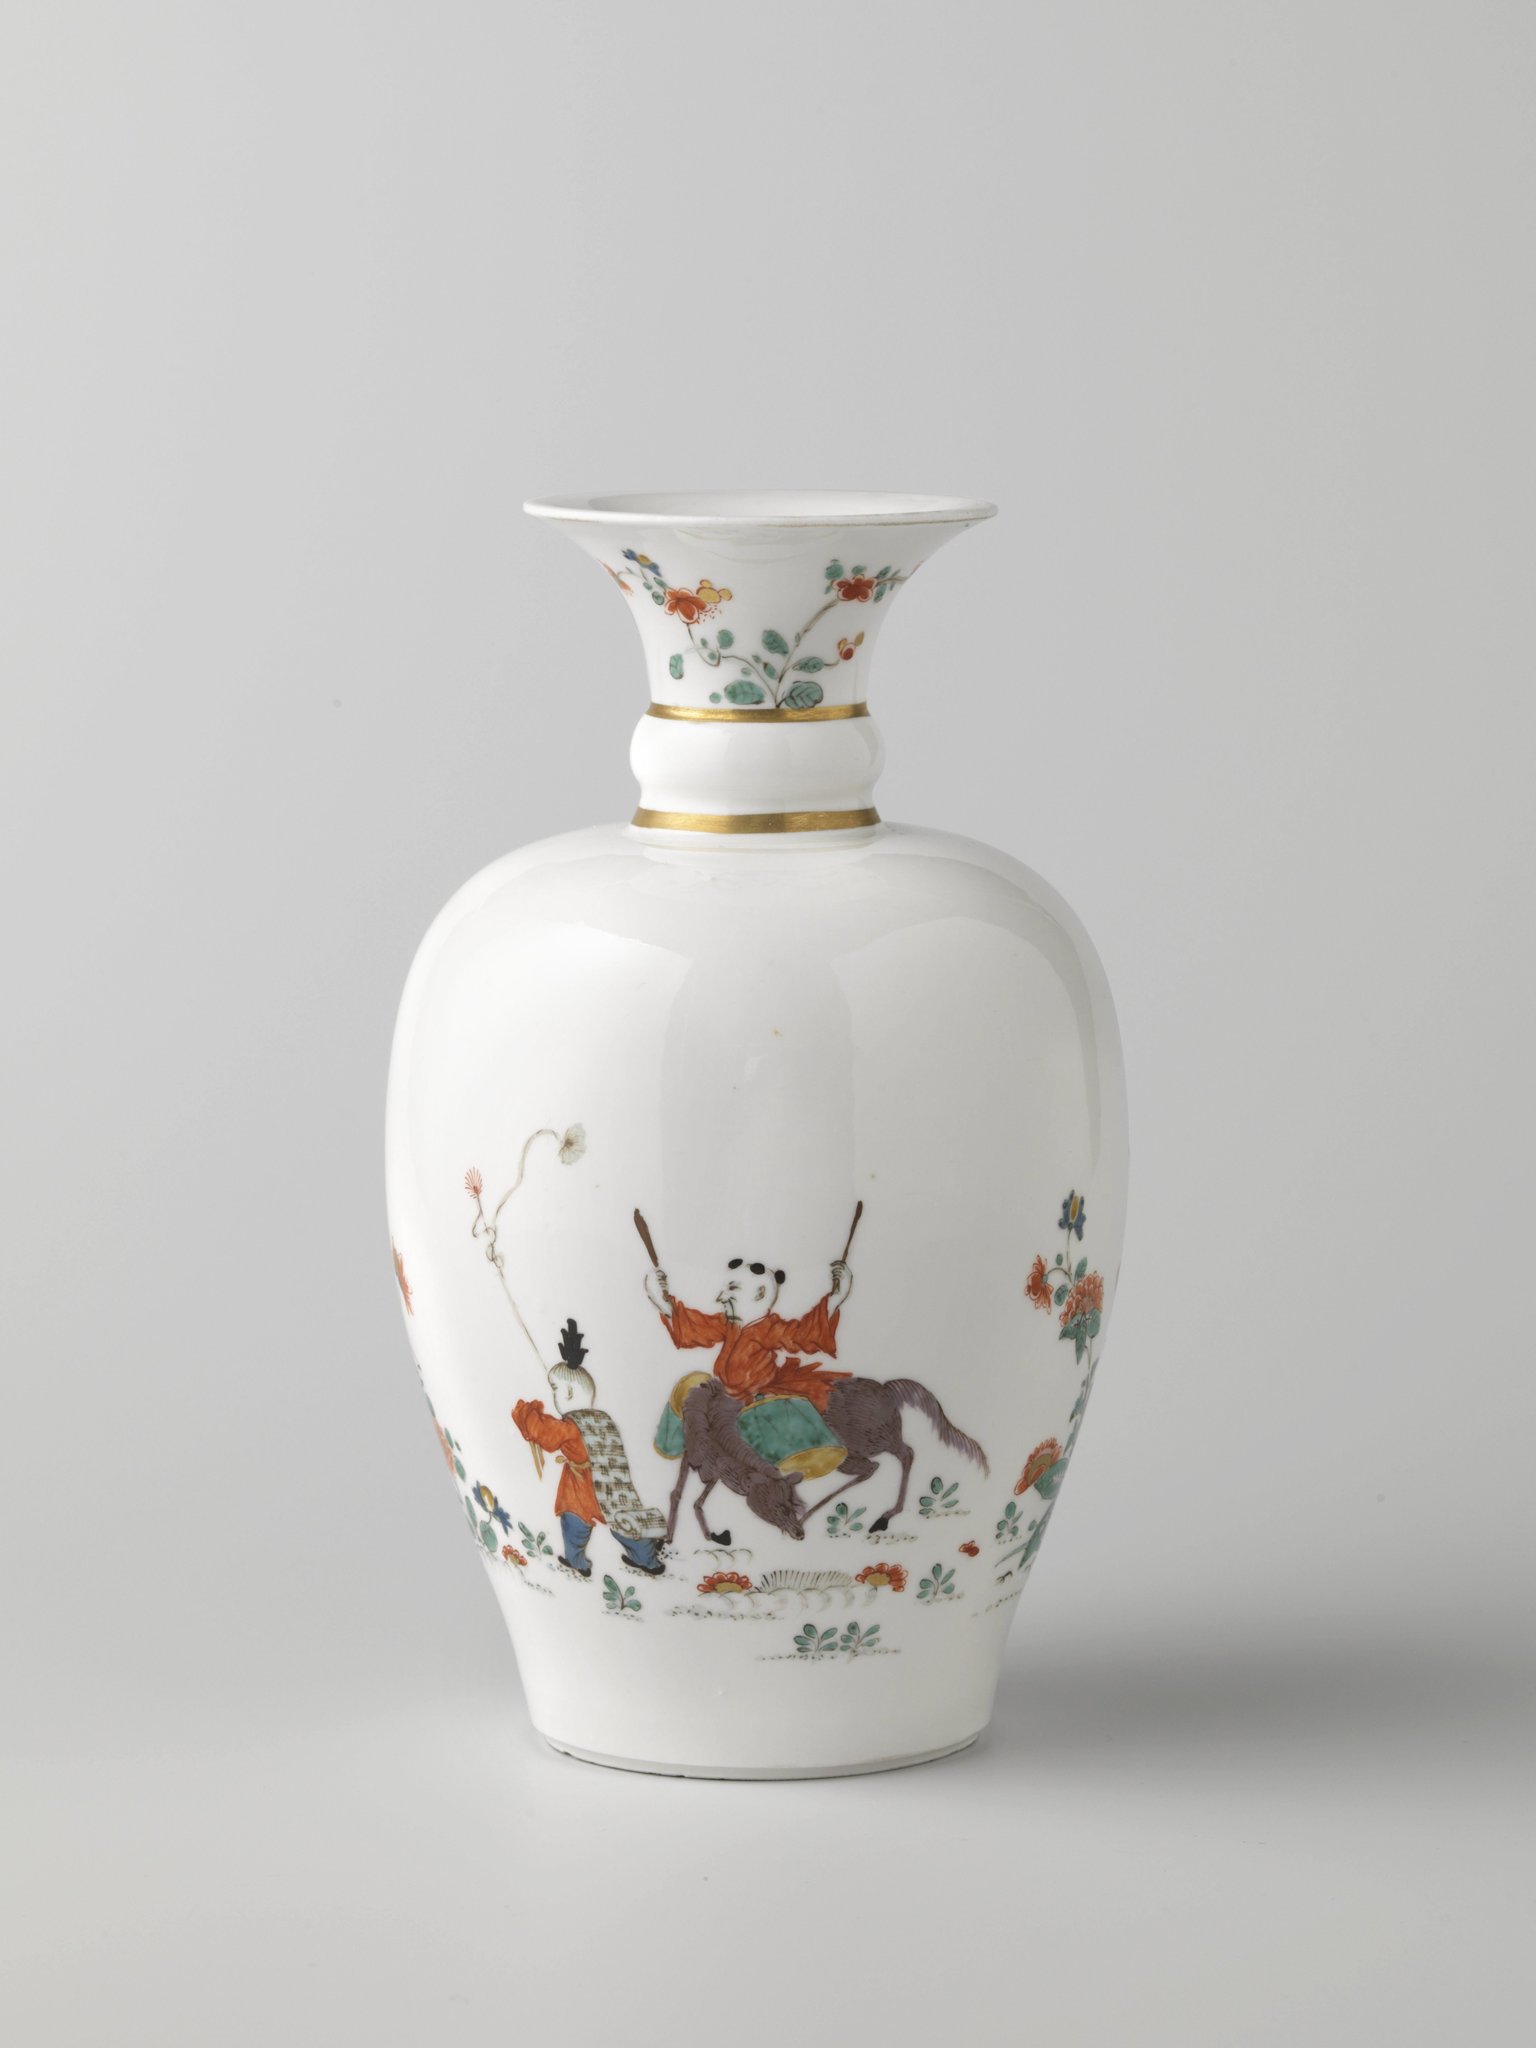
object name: vase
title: Vaas, veelkleurig beschilderd met chinoiserieën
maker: johann elias grund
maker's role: porseleinmodelleur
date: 1730-1735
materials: porcelain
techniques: painted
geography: meissen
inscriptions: factory mark: ‘AR’, mold mark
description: Plate. Porcelain. Meissen, c. 1735. Two vases. Porcelain. Meissen, c. 1730 - 1735.